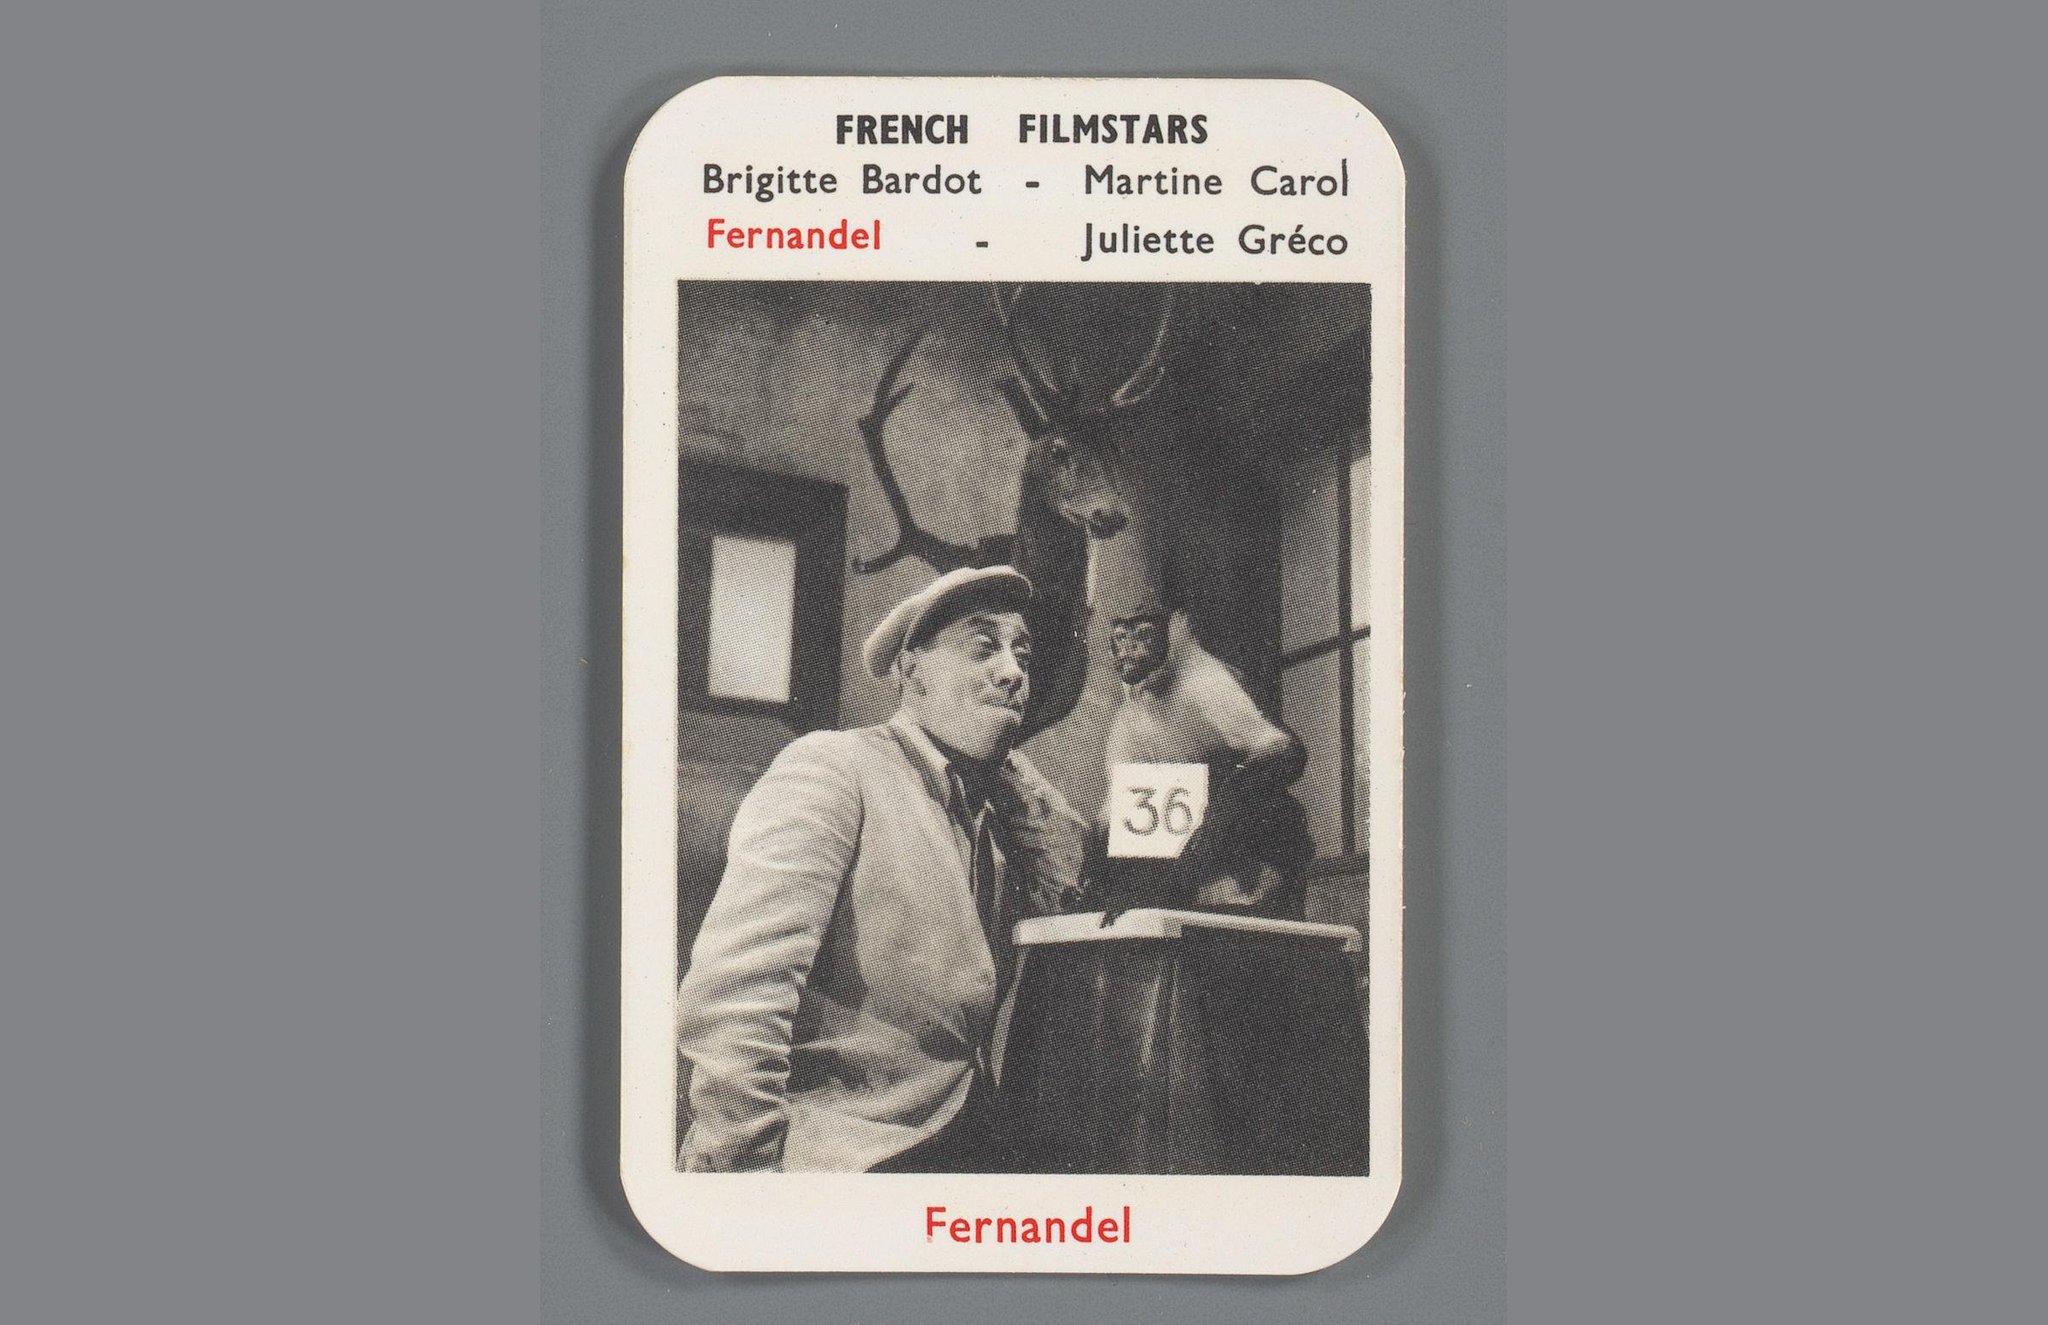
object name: playing card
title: Fernandel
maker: Anonymous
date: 1960-1970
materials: paper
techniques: autotype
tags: marseille, paris, portrait of actor, actress